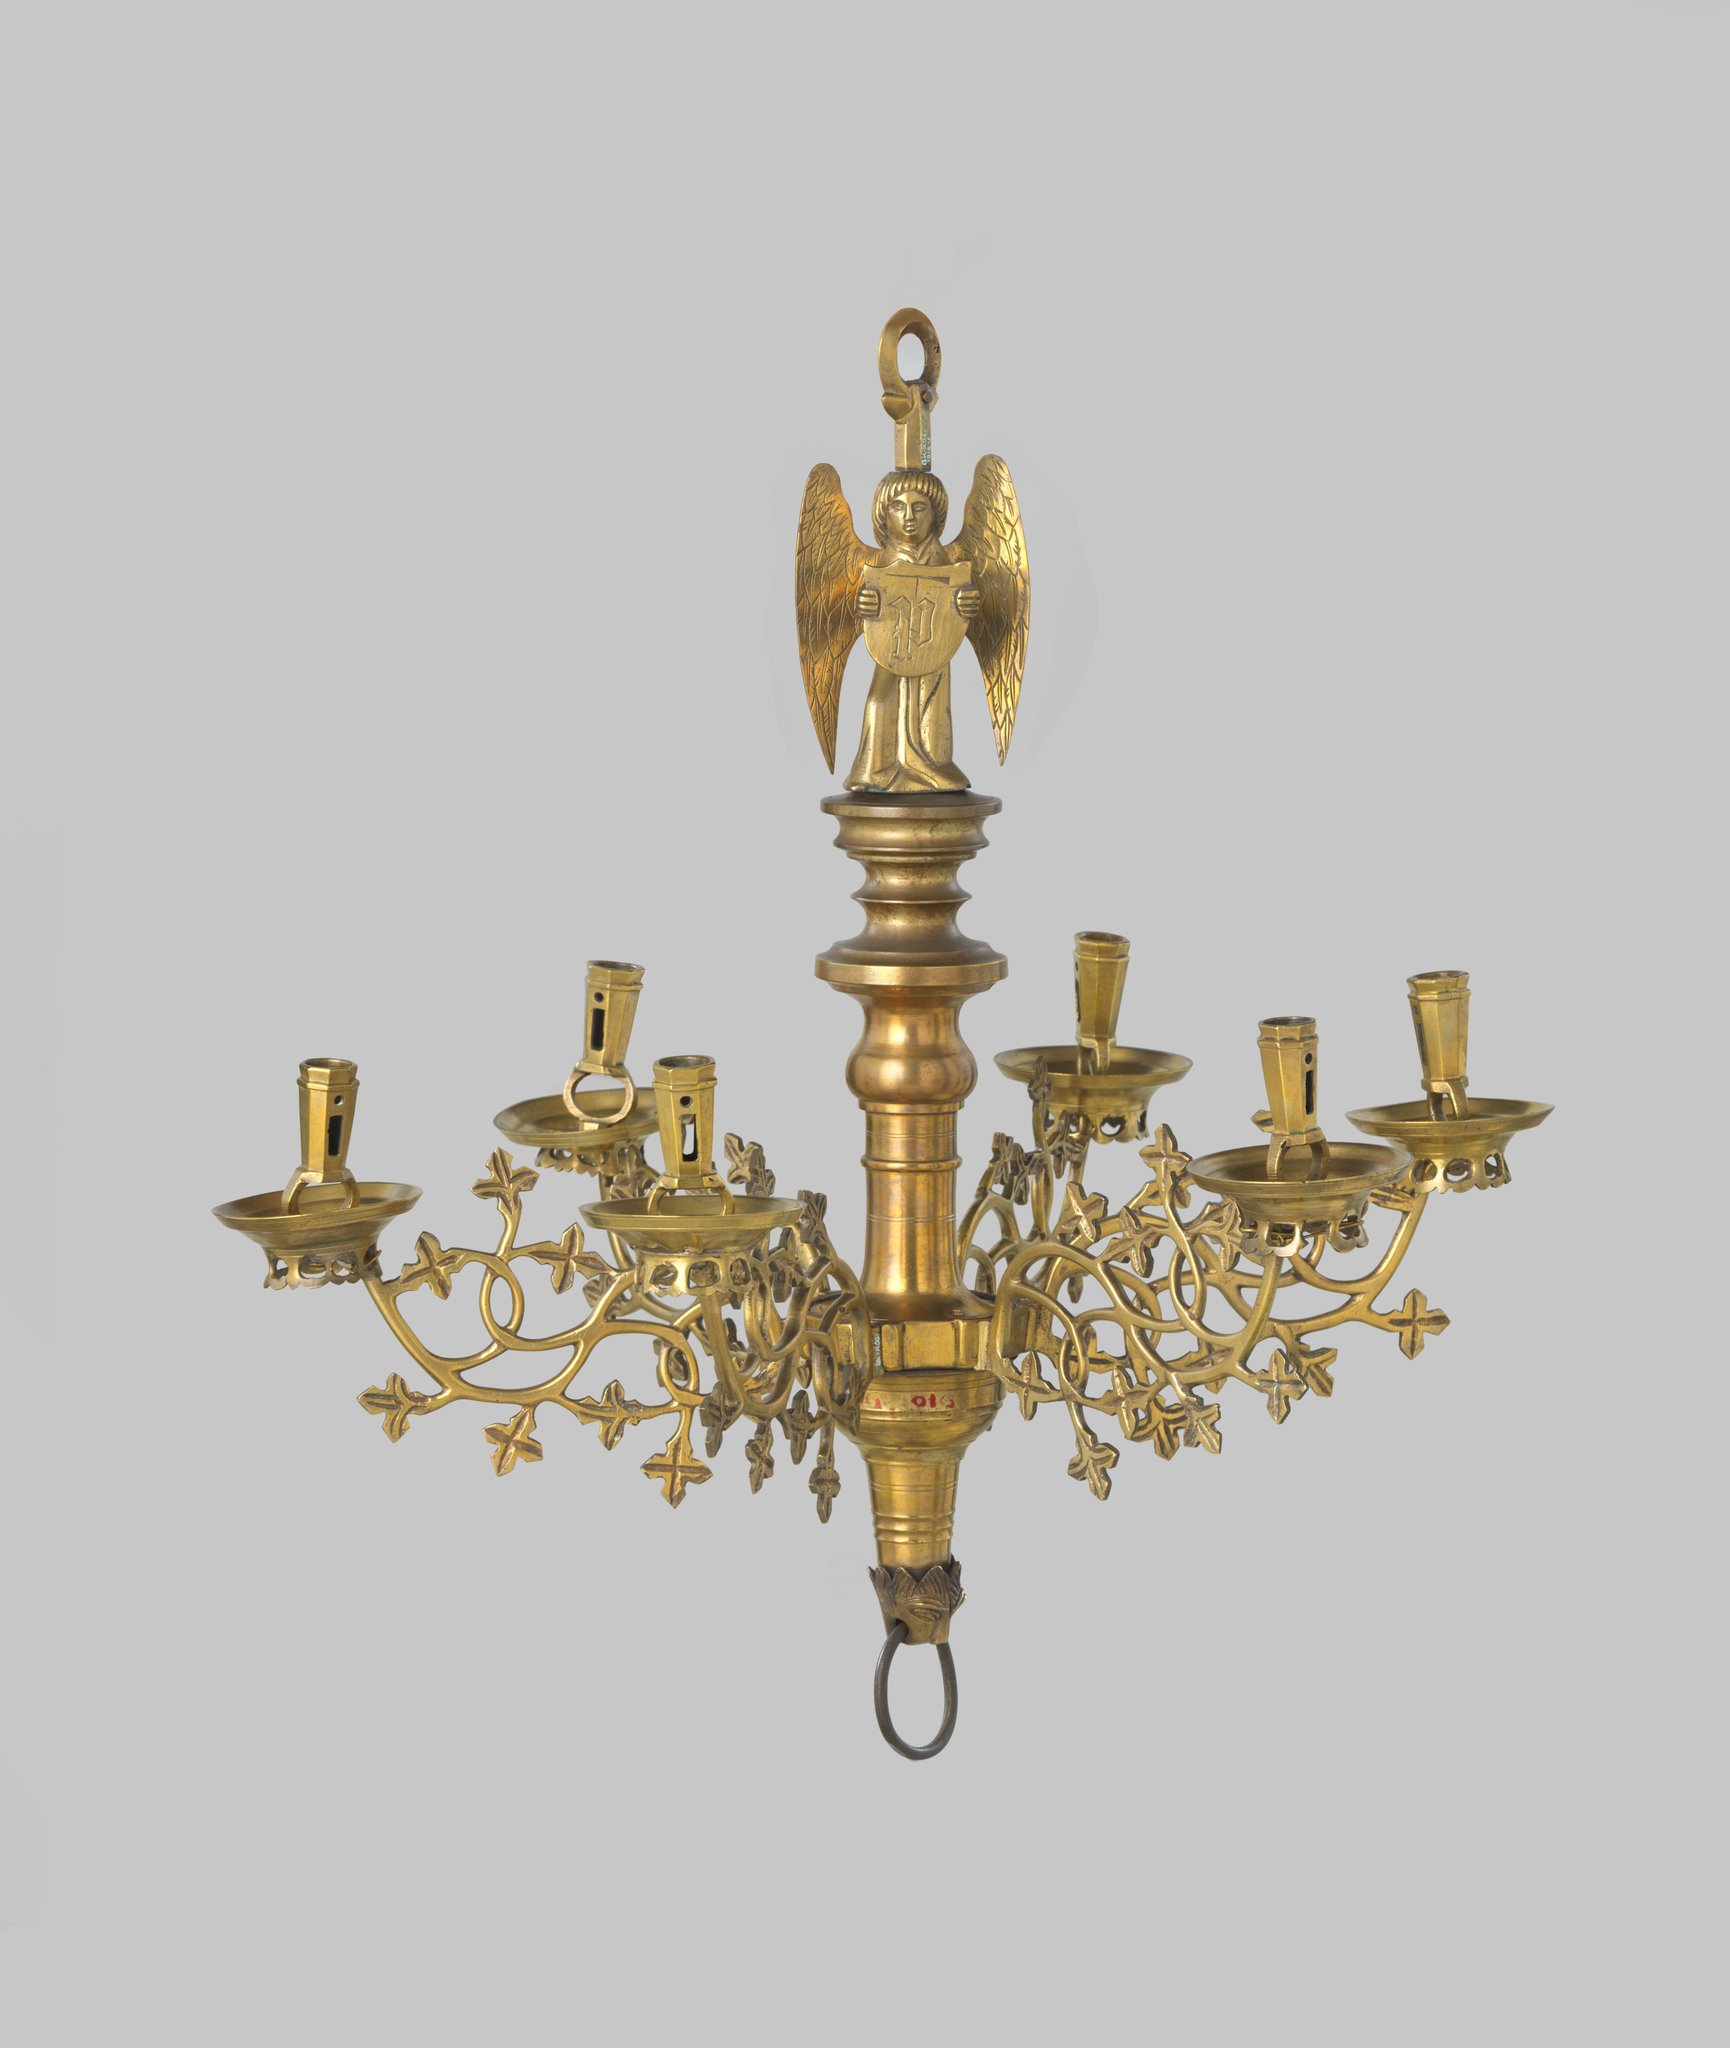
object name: chandelier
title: Stam van een kaarsenkroon met engel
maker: Anonymous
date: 1825-1875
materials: brass, iron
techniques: casting, forging, riveted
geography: western europe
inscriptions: inscription: ‘P’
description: Het voorwerp bestaat uit een ijzeren stang en de volgende gegoten delen: de hangring (die aan de stang is geklonken), de engel, het wapenschild met de handjes (die aldaar aan de armen zijn geklonken), het uit koperplaat gemaakte deel met de twee vleugels (dat met een pin op de rug van de engel is bevestigd), het bovenste stamdeel, de standring met zes gleuven, het onderste stamdeel, de leeuwenkop (welke vier delen tot een geheel zijn geklonken), de trekring. De geknielde engel houdt een schild op met de letter P in gotisch minuskelschrift. Het bovenste stamdeel is overwegend bol- en holrond geprofileerd en is tevens met twee paar gegroefde ringen versierd. Het onderste stamdeel verjongt zich naar beneden toe en heeft zes paar gegroefde ringen. De gleuven in de standring zijn genummerd met één t/m zes ingeslagen driehoeken.